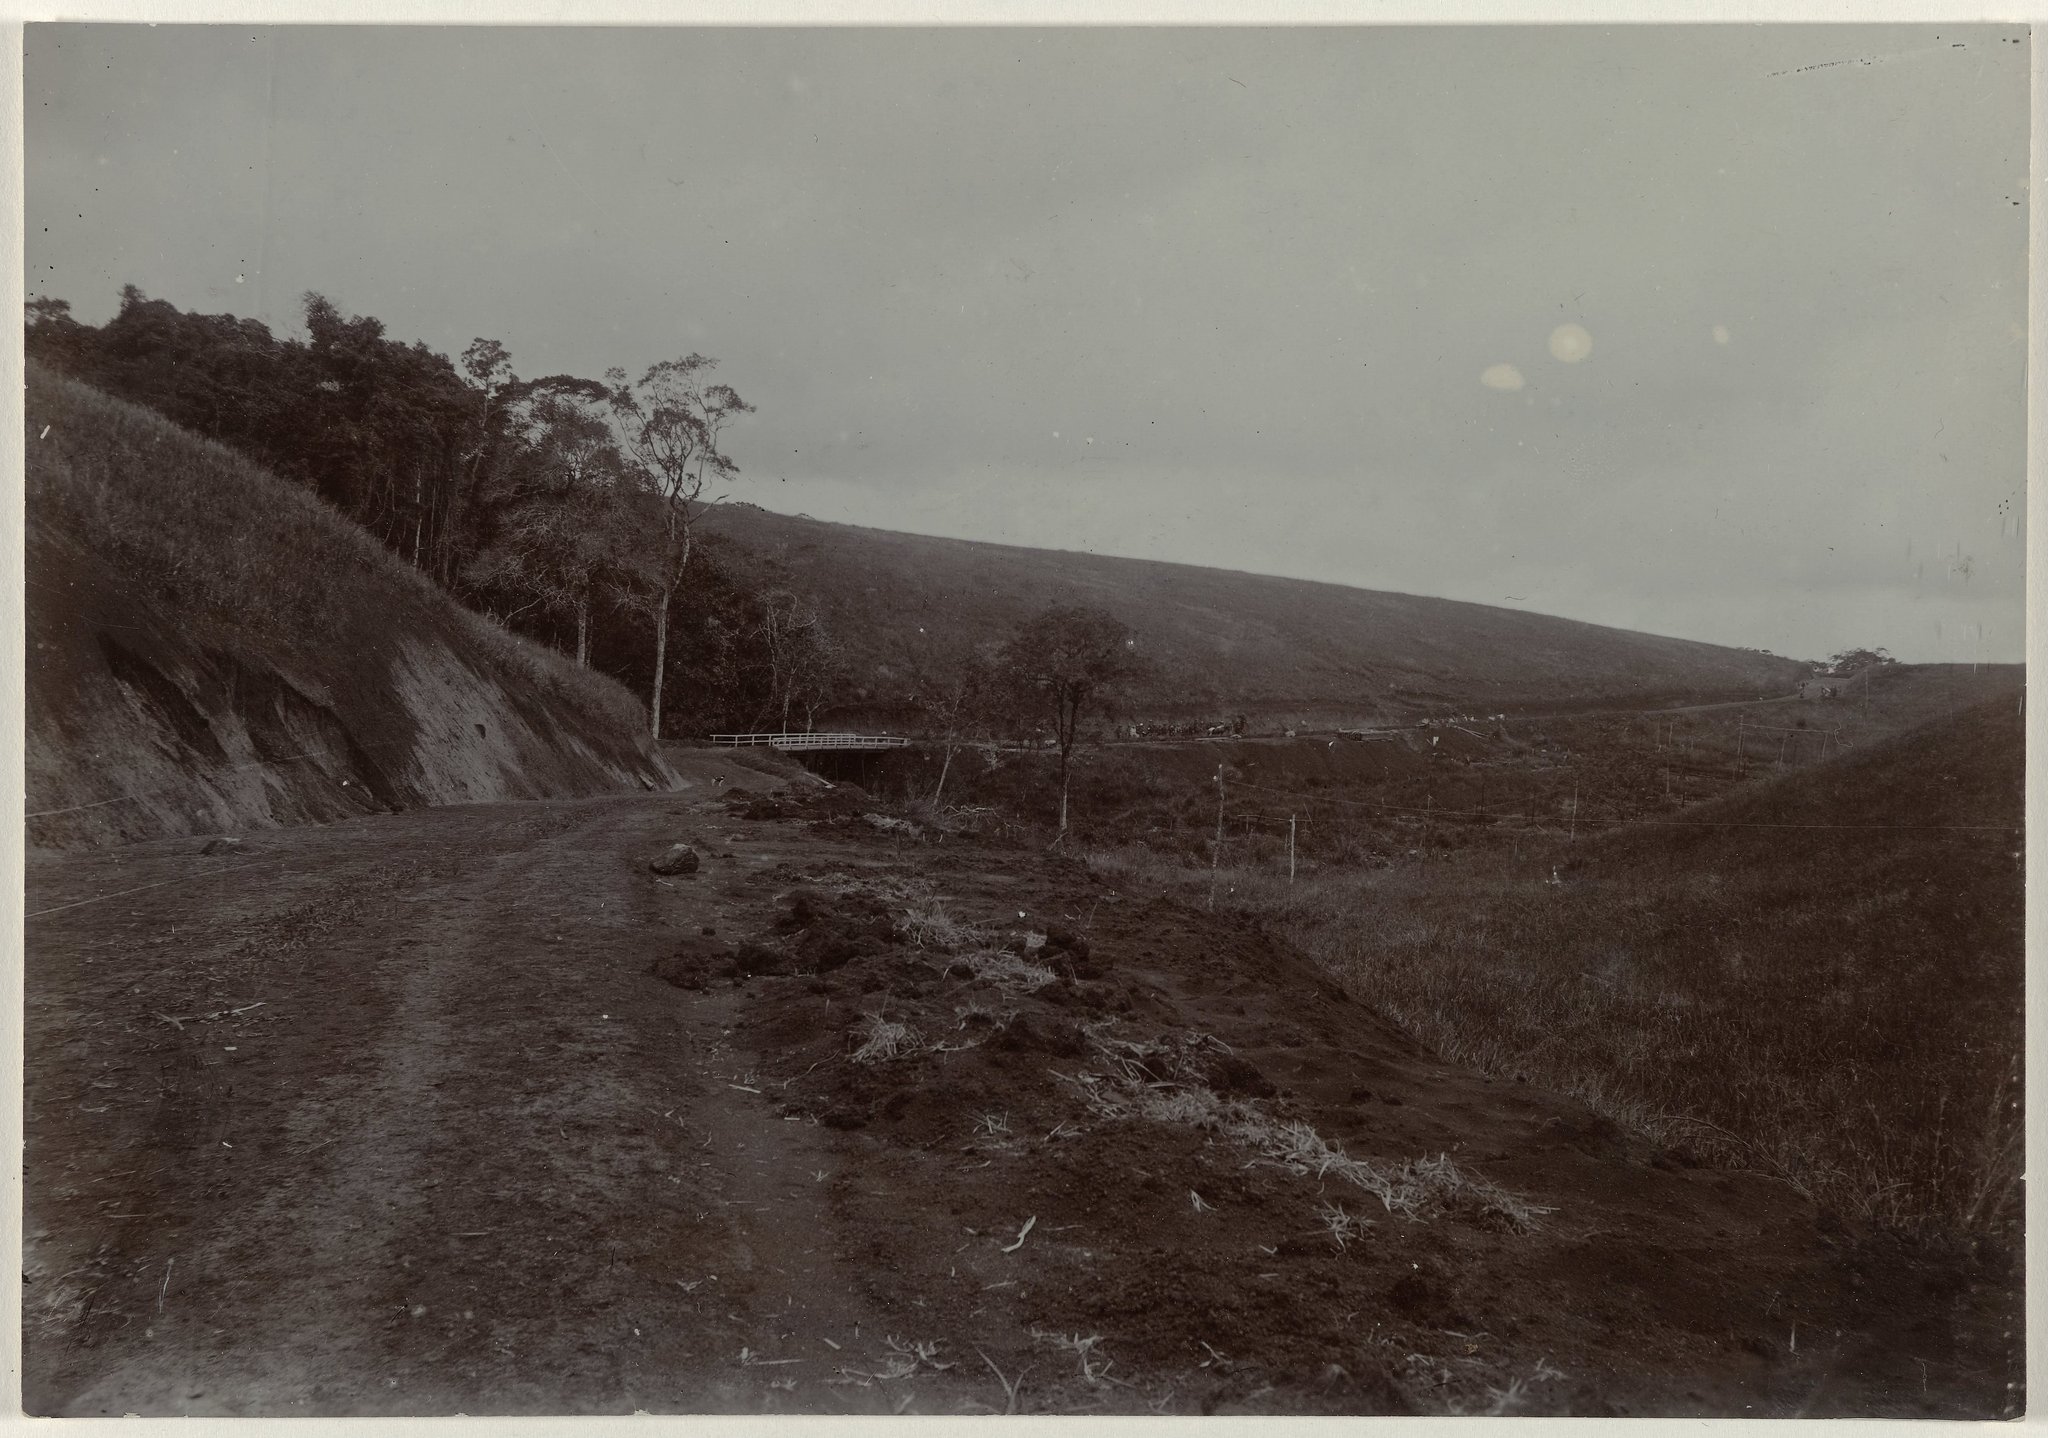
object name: photograph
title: Aanleg van de weg met een brug langs een helling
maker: Anonymous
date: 1903-1913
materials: photographic support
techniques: photography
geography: north sumatra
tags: (high) hill, bridge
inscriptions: inscription: ‘Aloei Gadeng / KM 56.3’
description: Na de expedities naar de Gajo- en Alaslanden o.l.v. Van Daalen (eerste tocht in 1901), werd hij in 1903 belast met voorbereiding van permanente vestiging van Nederlands gezag. Aanleg van een weg van de Noordkust naar het binnenland was hierbij van groot belang. Deze zgn. Gajoweg werd aangelegd tussen 1903 en 1914, van Bireuen aan de kust naar Takinguen aan het bergmeer Danau Lauttawar, totale lengte 104 km.